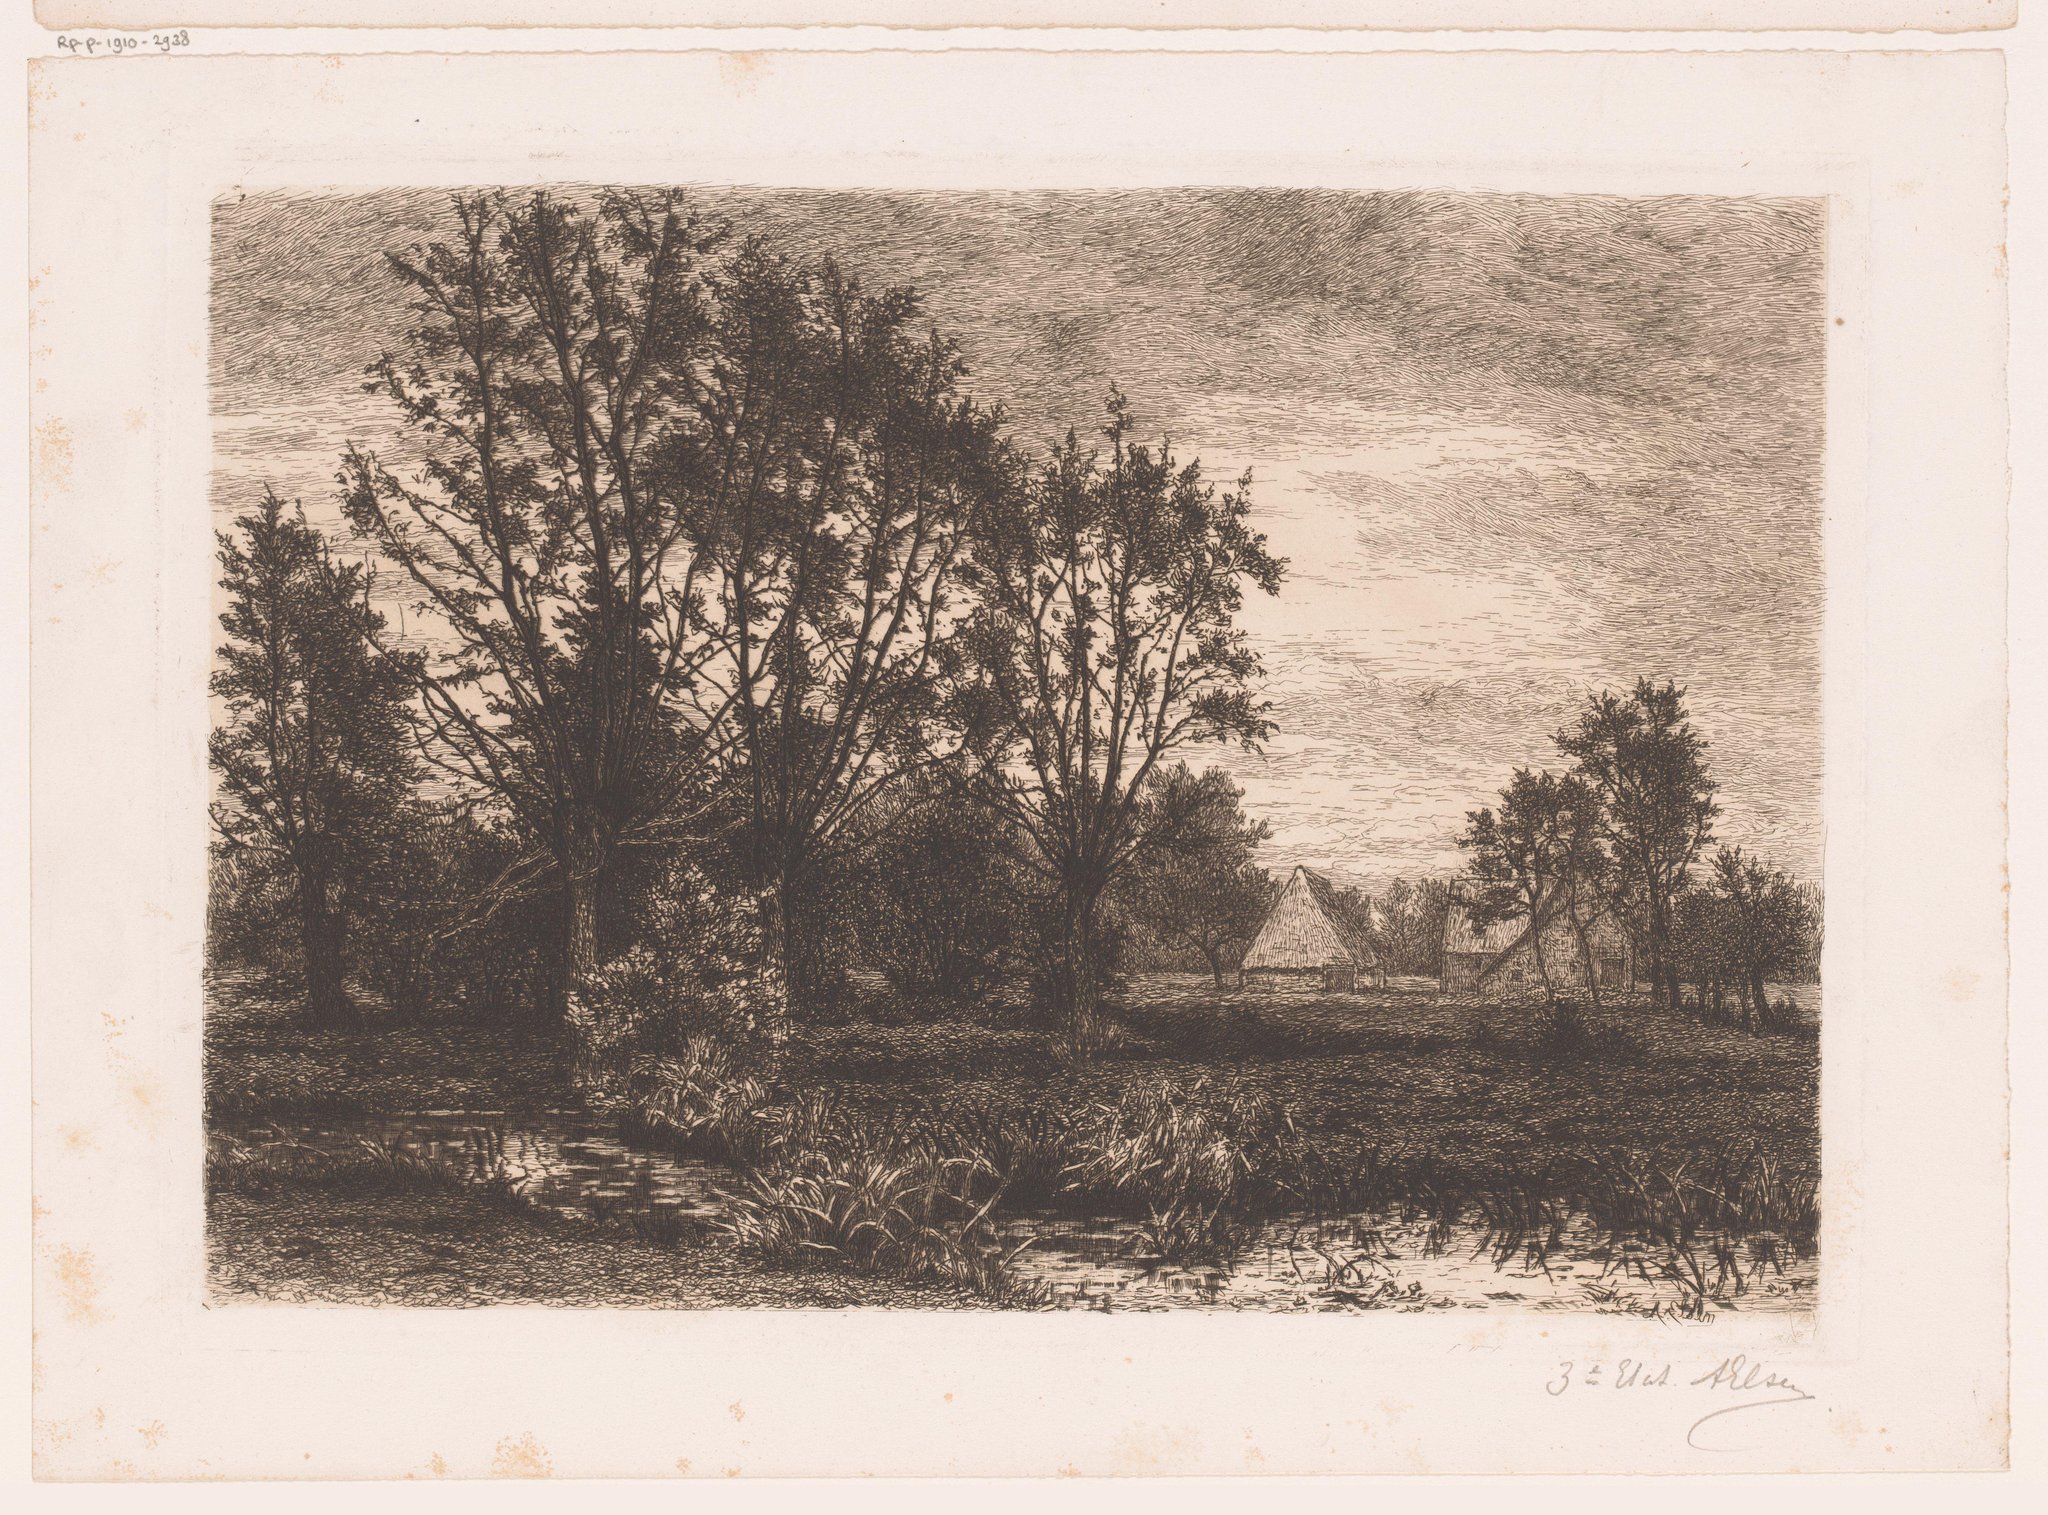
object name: print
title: Landschap met vier wilgen en een beek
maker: alfred elsen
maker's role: painter, print maker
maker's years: 1850-1914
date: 1881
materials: paper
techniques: etching, intaglio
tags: brook, trees: willow, farm or solitary house in landscape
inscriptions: inscription: ‘3e Etat’, collector's mark: Lugt 2228